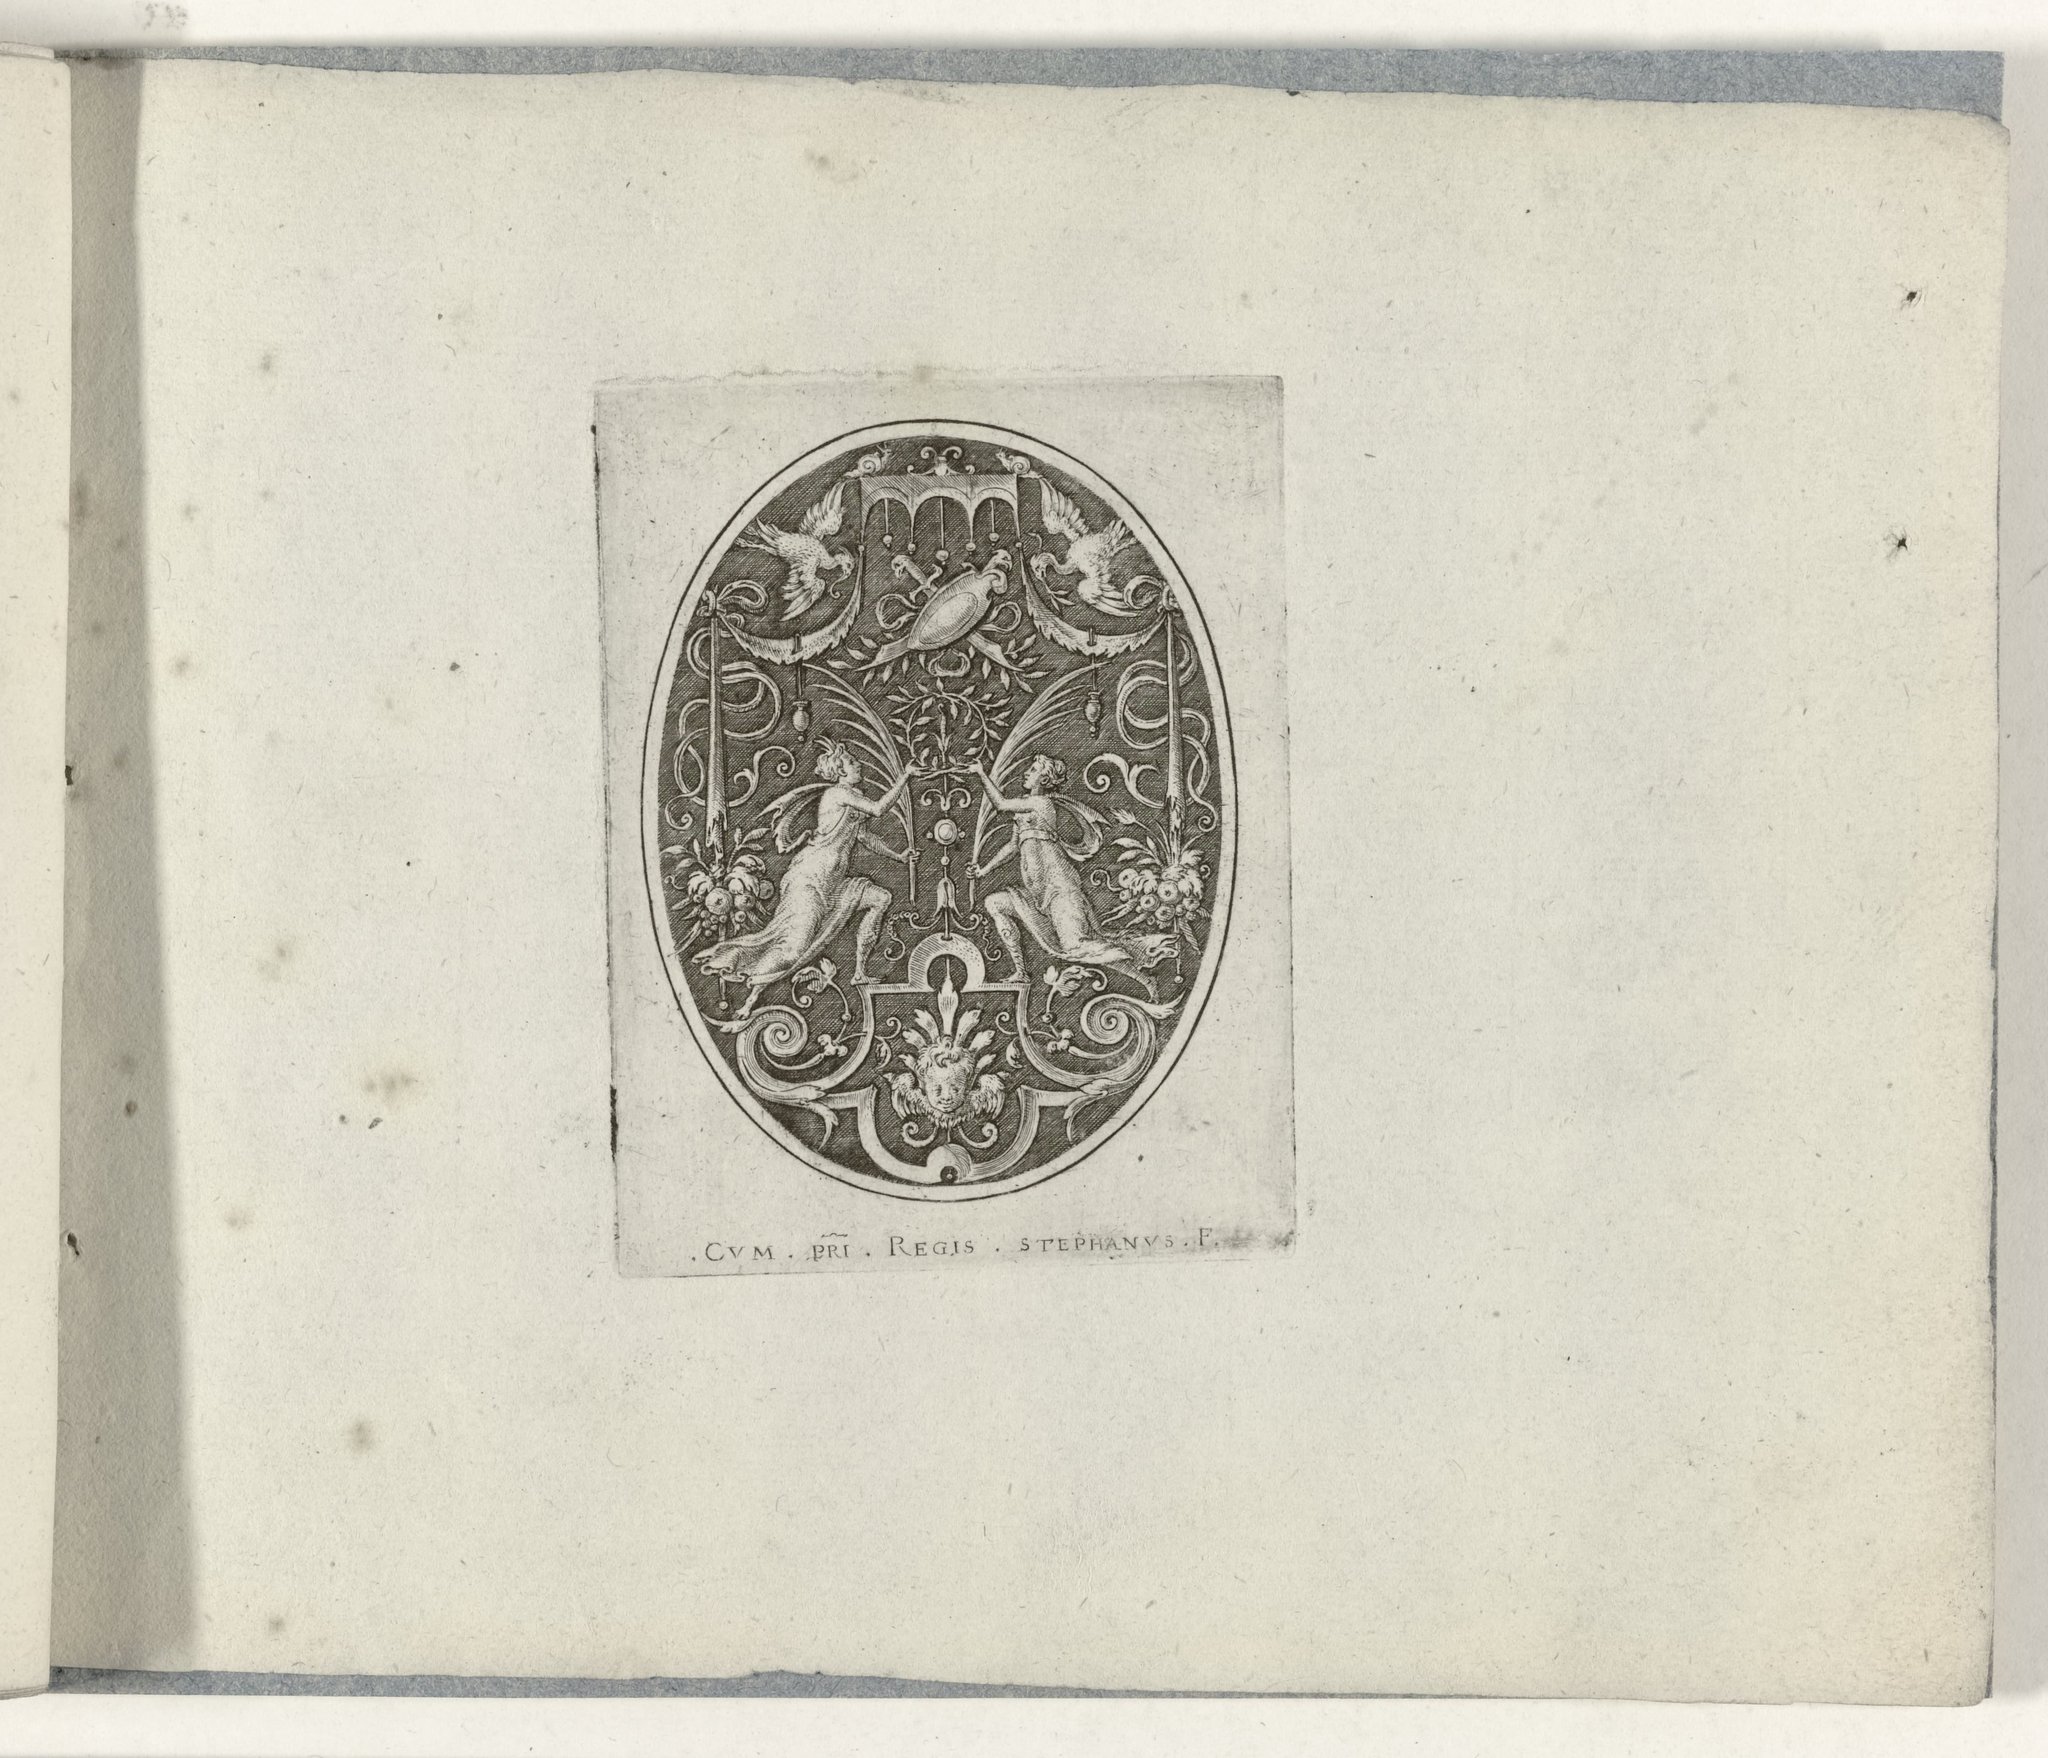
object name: print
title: Twee vrouwen, elk met palmtak, die knielen onder een wapentrofee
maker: etienne delaune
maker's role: draughtsman, goldsmith, print maker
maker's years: 1519-1583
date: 1560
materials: paper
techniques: engraving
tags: anthropomorphic ornament